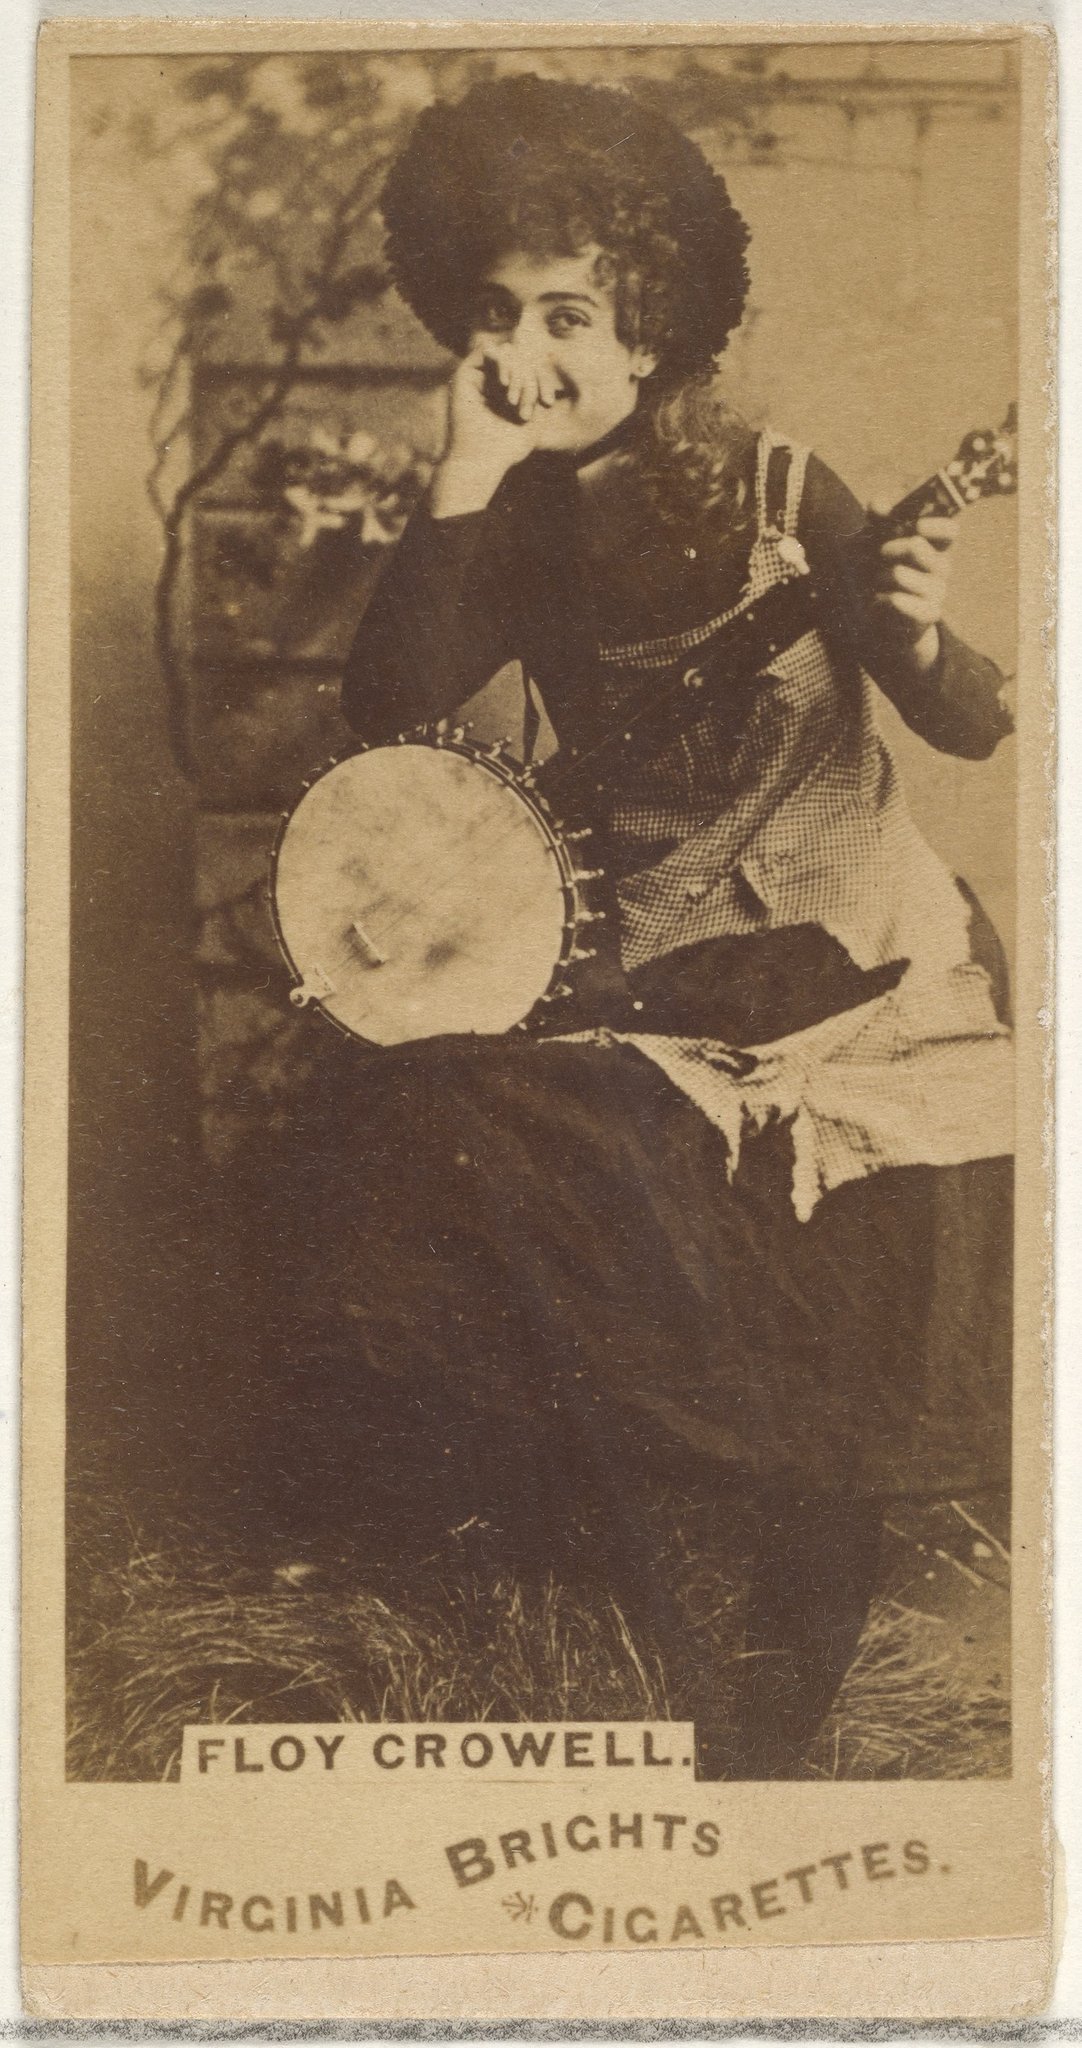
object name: photograph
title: Floy Crowell, from the Actors and Actresses series (N45, Type 1) for Virginia Brights Cigarettes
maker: allen & ginter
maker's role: publisher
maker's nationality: american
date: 1888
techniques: albumen silver print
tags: musical instruments,portraits,women,actresses